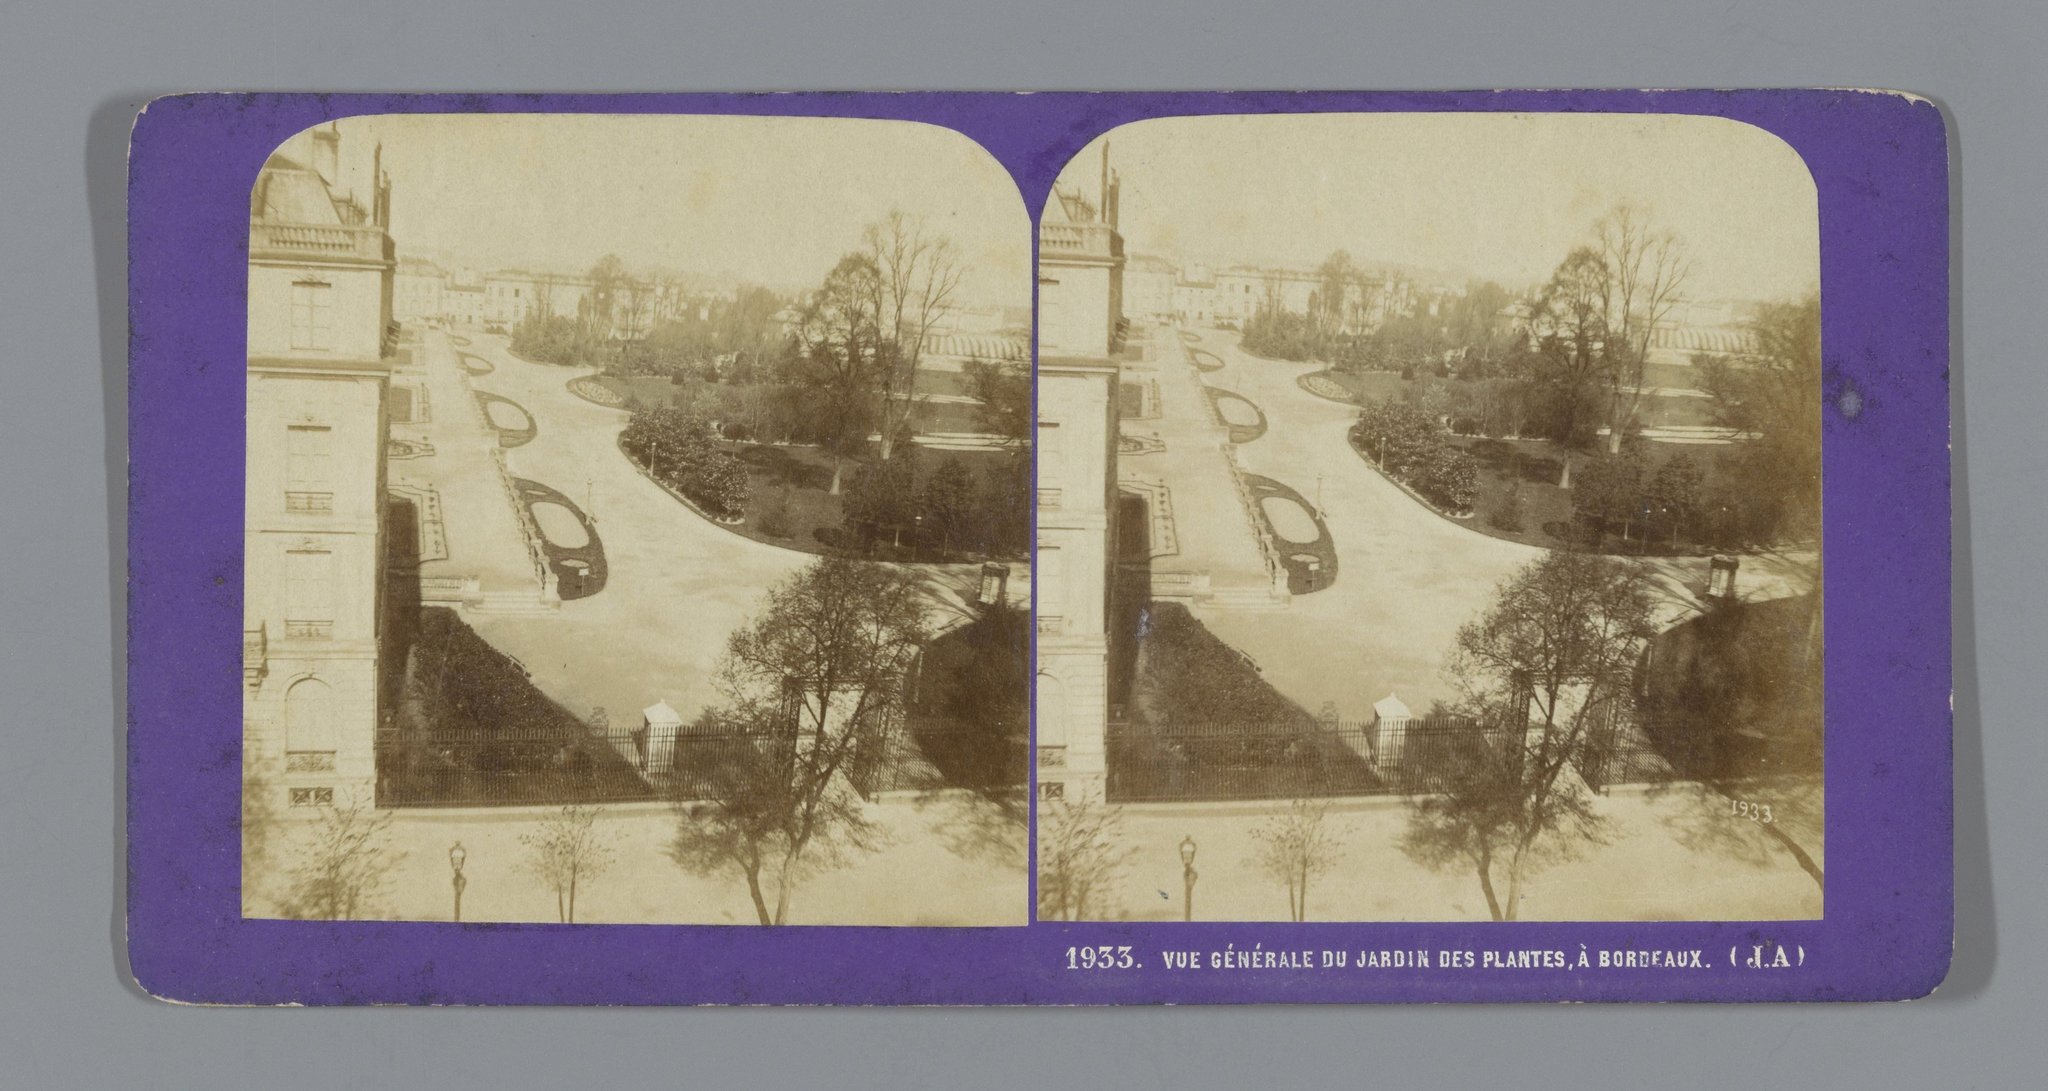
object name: stereograph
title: Vue générale du Jardin des Plantes, à Bordeaux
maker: jean andrieu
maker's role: fotograaf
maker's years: 1816-1872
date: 1862-1876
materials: cardboard, photographic support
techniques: albumen print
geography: bordeaux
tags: botanic garden, 'hortus botanicus'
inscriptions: number: ‘1933’